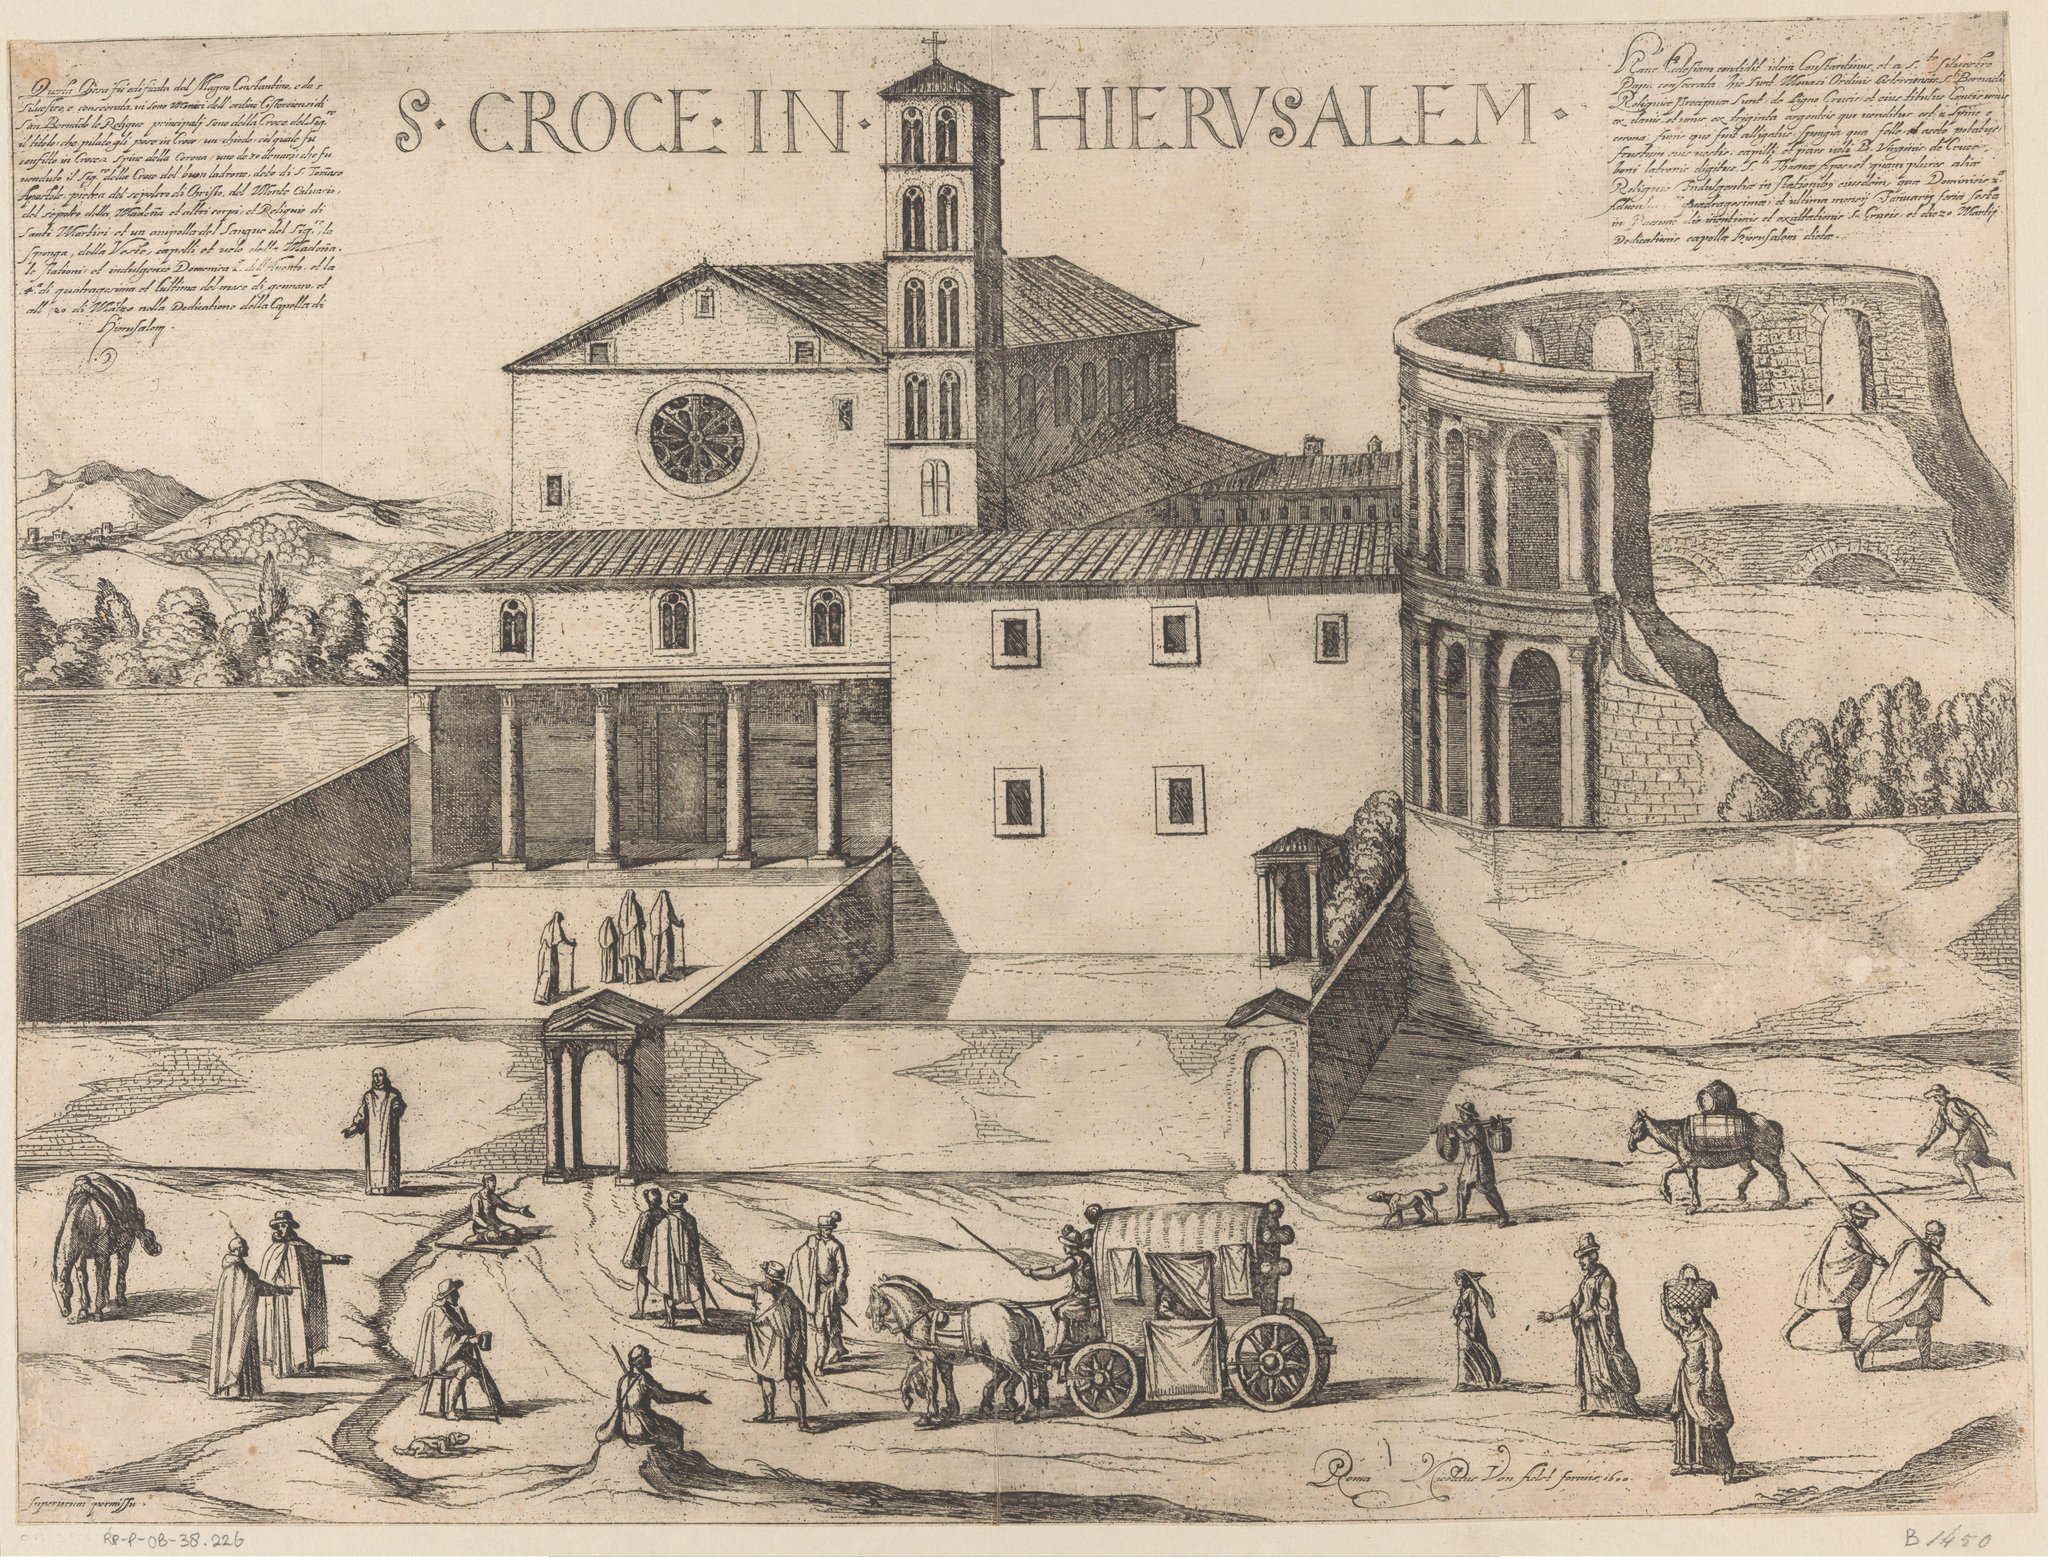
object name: print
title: Santa Croce in Gerusalemme te Rome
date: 1600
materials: paper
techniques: etching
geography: rome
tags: church (exterior), roman catholic church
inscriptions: collector's mark: Lugt 240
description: Deze prent maakt deel uit van een reeks van negen prenten van de negen hoofdkerken van Rome.